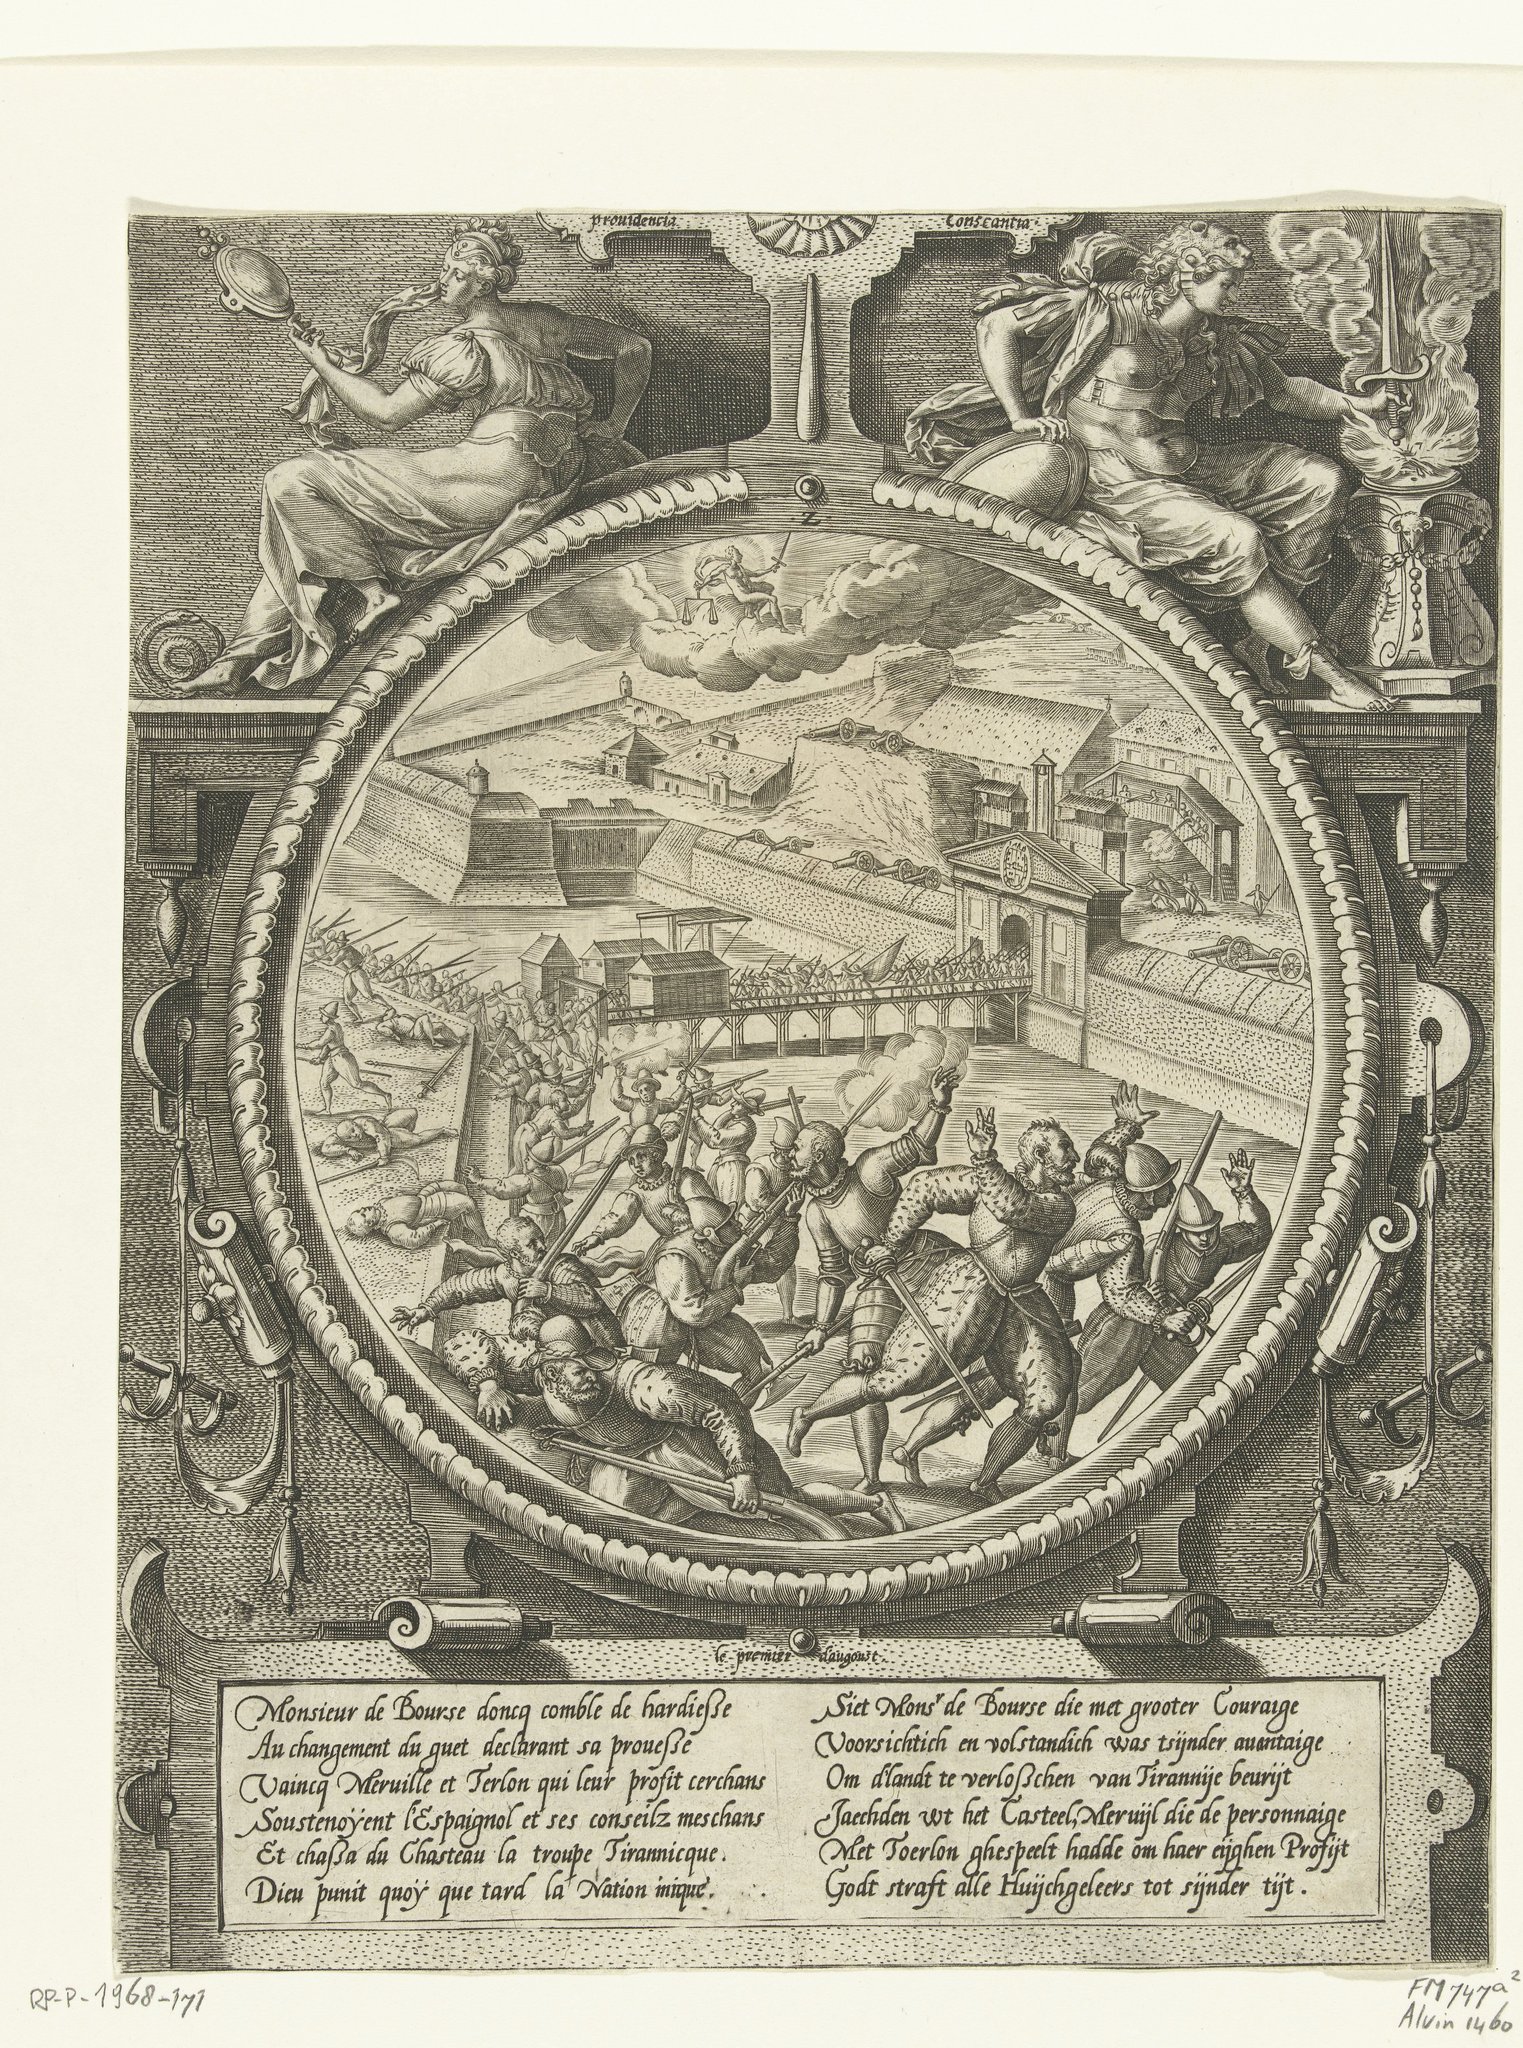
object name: print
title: De troepen van Bourse verdrijven de Duitse soldaten van Treslong en Merville uit de citadel, 1577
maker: wierix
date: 1578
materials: paper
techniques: engraving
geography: southern netherlands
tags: justice, 'justitia'; 'giustitia divina' (ripa) ~ one of the four cardinal virtues, capture of city (after the siege), forethought, deliberation; 'previdenza', 'providenza' (ripa), constancy, tenacity; 'costanza', 'tenacità' (ripa)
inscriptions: collector's mark: Lugt 2760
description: De troepen van Bourse verdrijven de Duitse soldaten van Treslong en Merville uit de citadel, 1 augustus 1577. In de wolken Rechtvaardigheid. Voorstelling in een rond medaillon met ornamentele allegorische omlijsting met bovenaan de zittende vrouwelijke personificaties van Voorzienigheid (Providentia) en Standvastigheid (Constantia). Onderaan een cartouche met 2 verzen van elk 6 regels in het Frans en Nederlands.